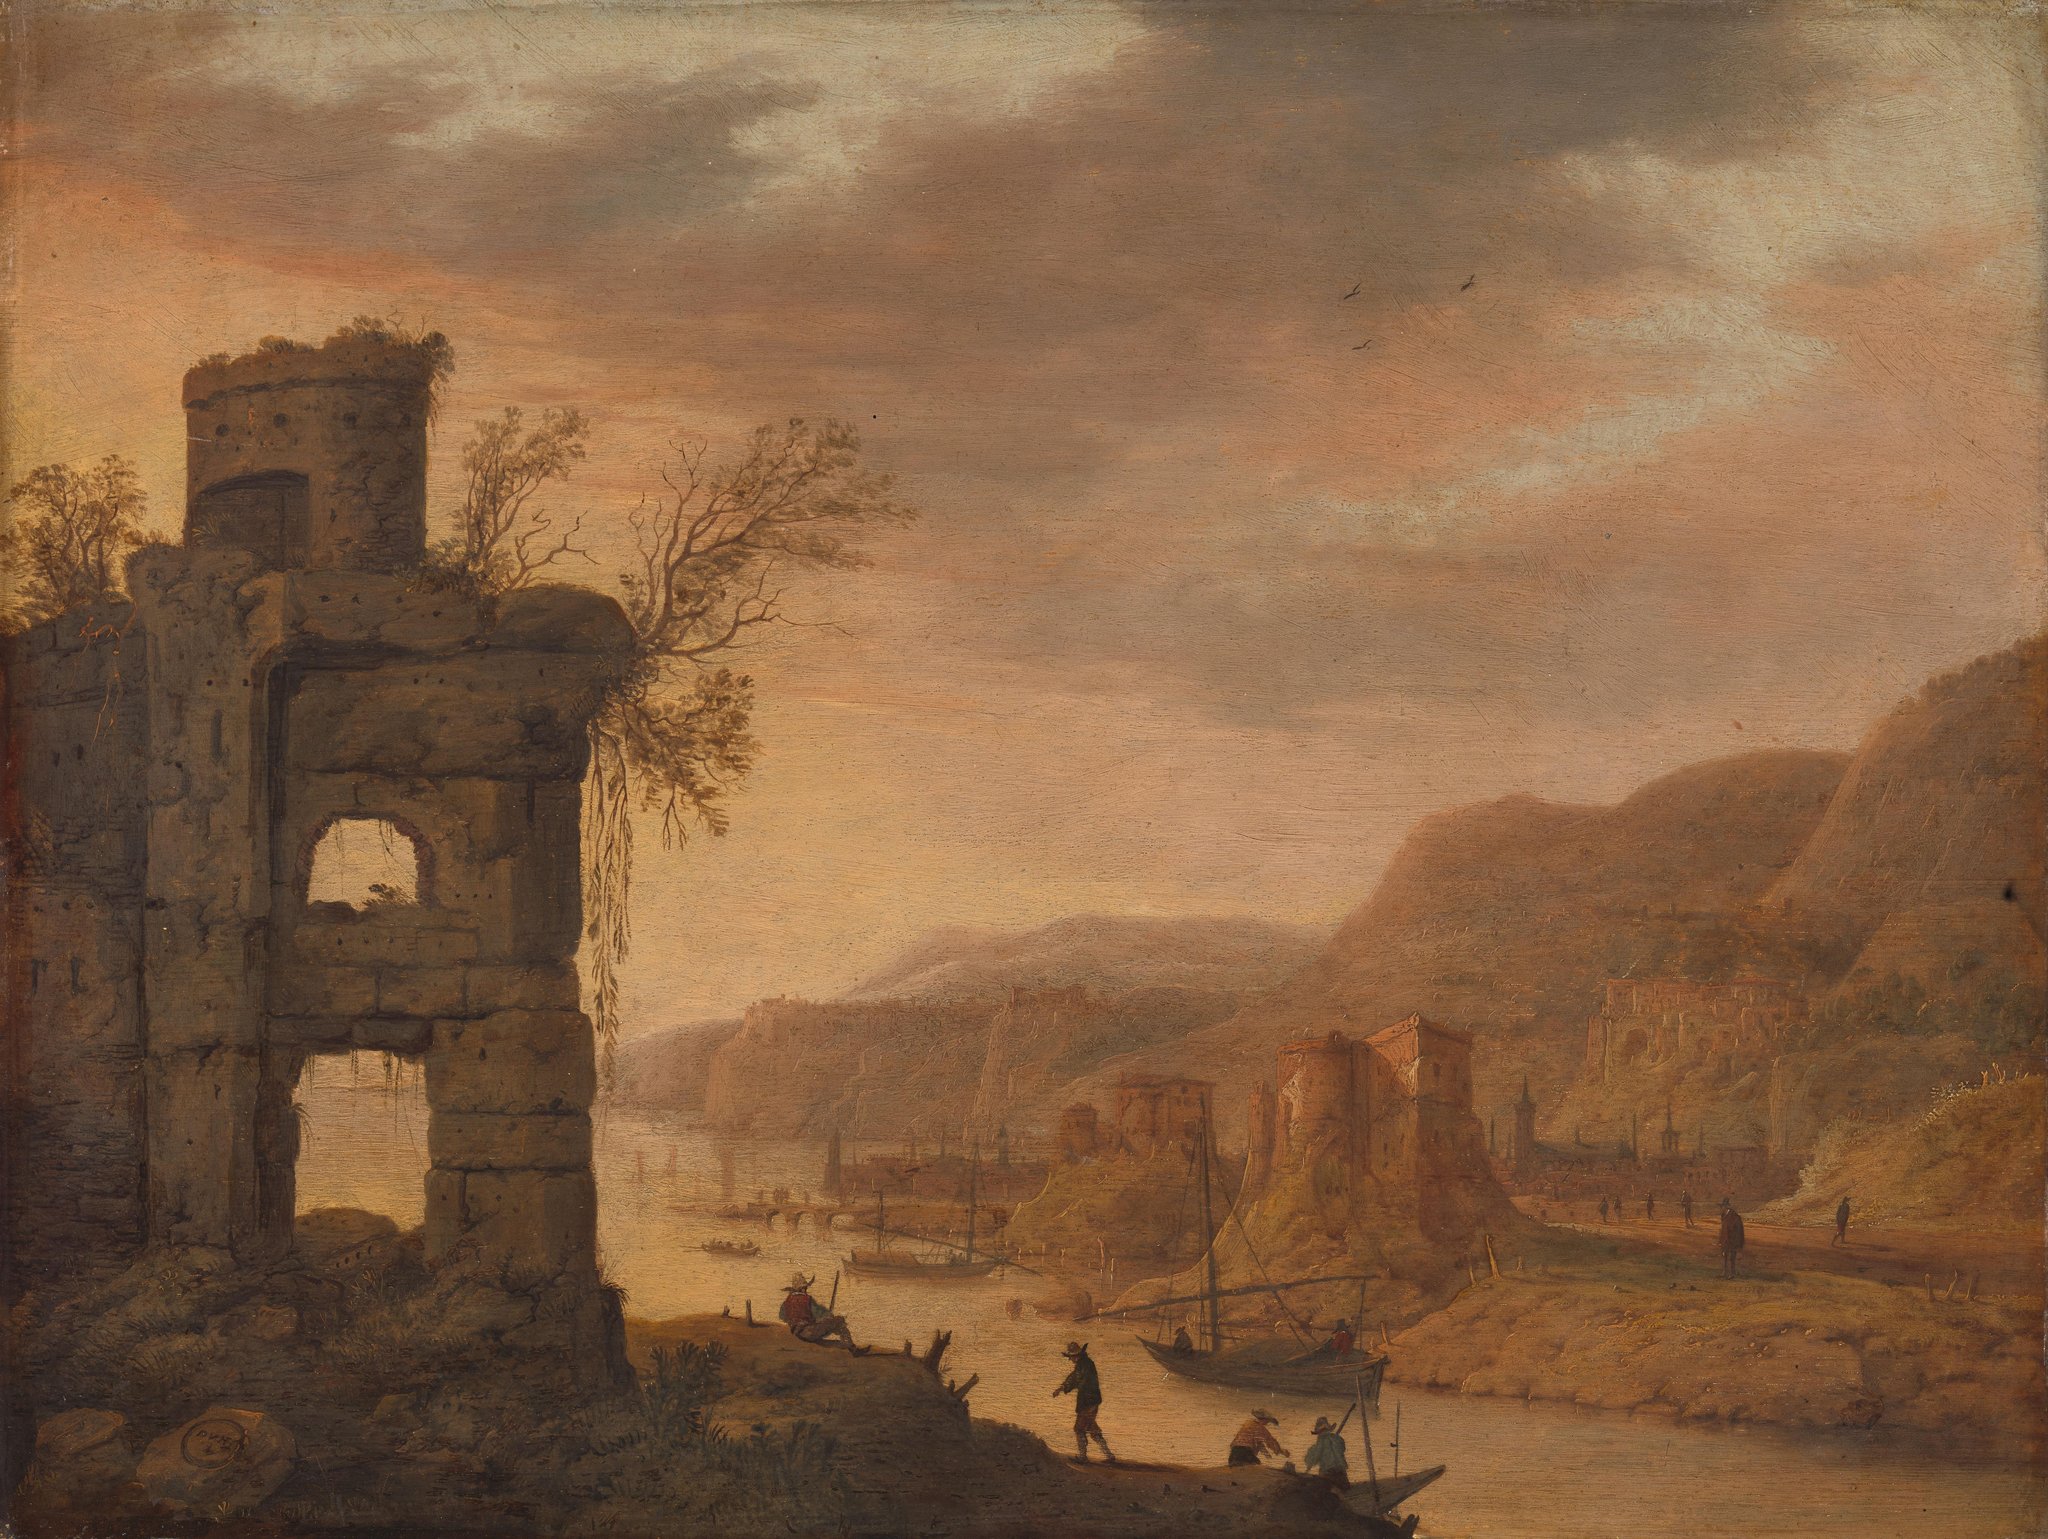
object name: painting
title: River Landscape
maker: dirck verhaert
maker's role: painter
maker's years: 1605-1685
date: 1630-1675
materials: oil, panel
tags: river, landscape with ruins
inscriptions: signature: ‘DVHf’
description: Rivierlandschap, links op de voorgrond een ruïne. In de verte torens en een stad langs een rotsachtige kust.